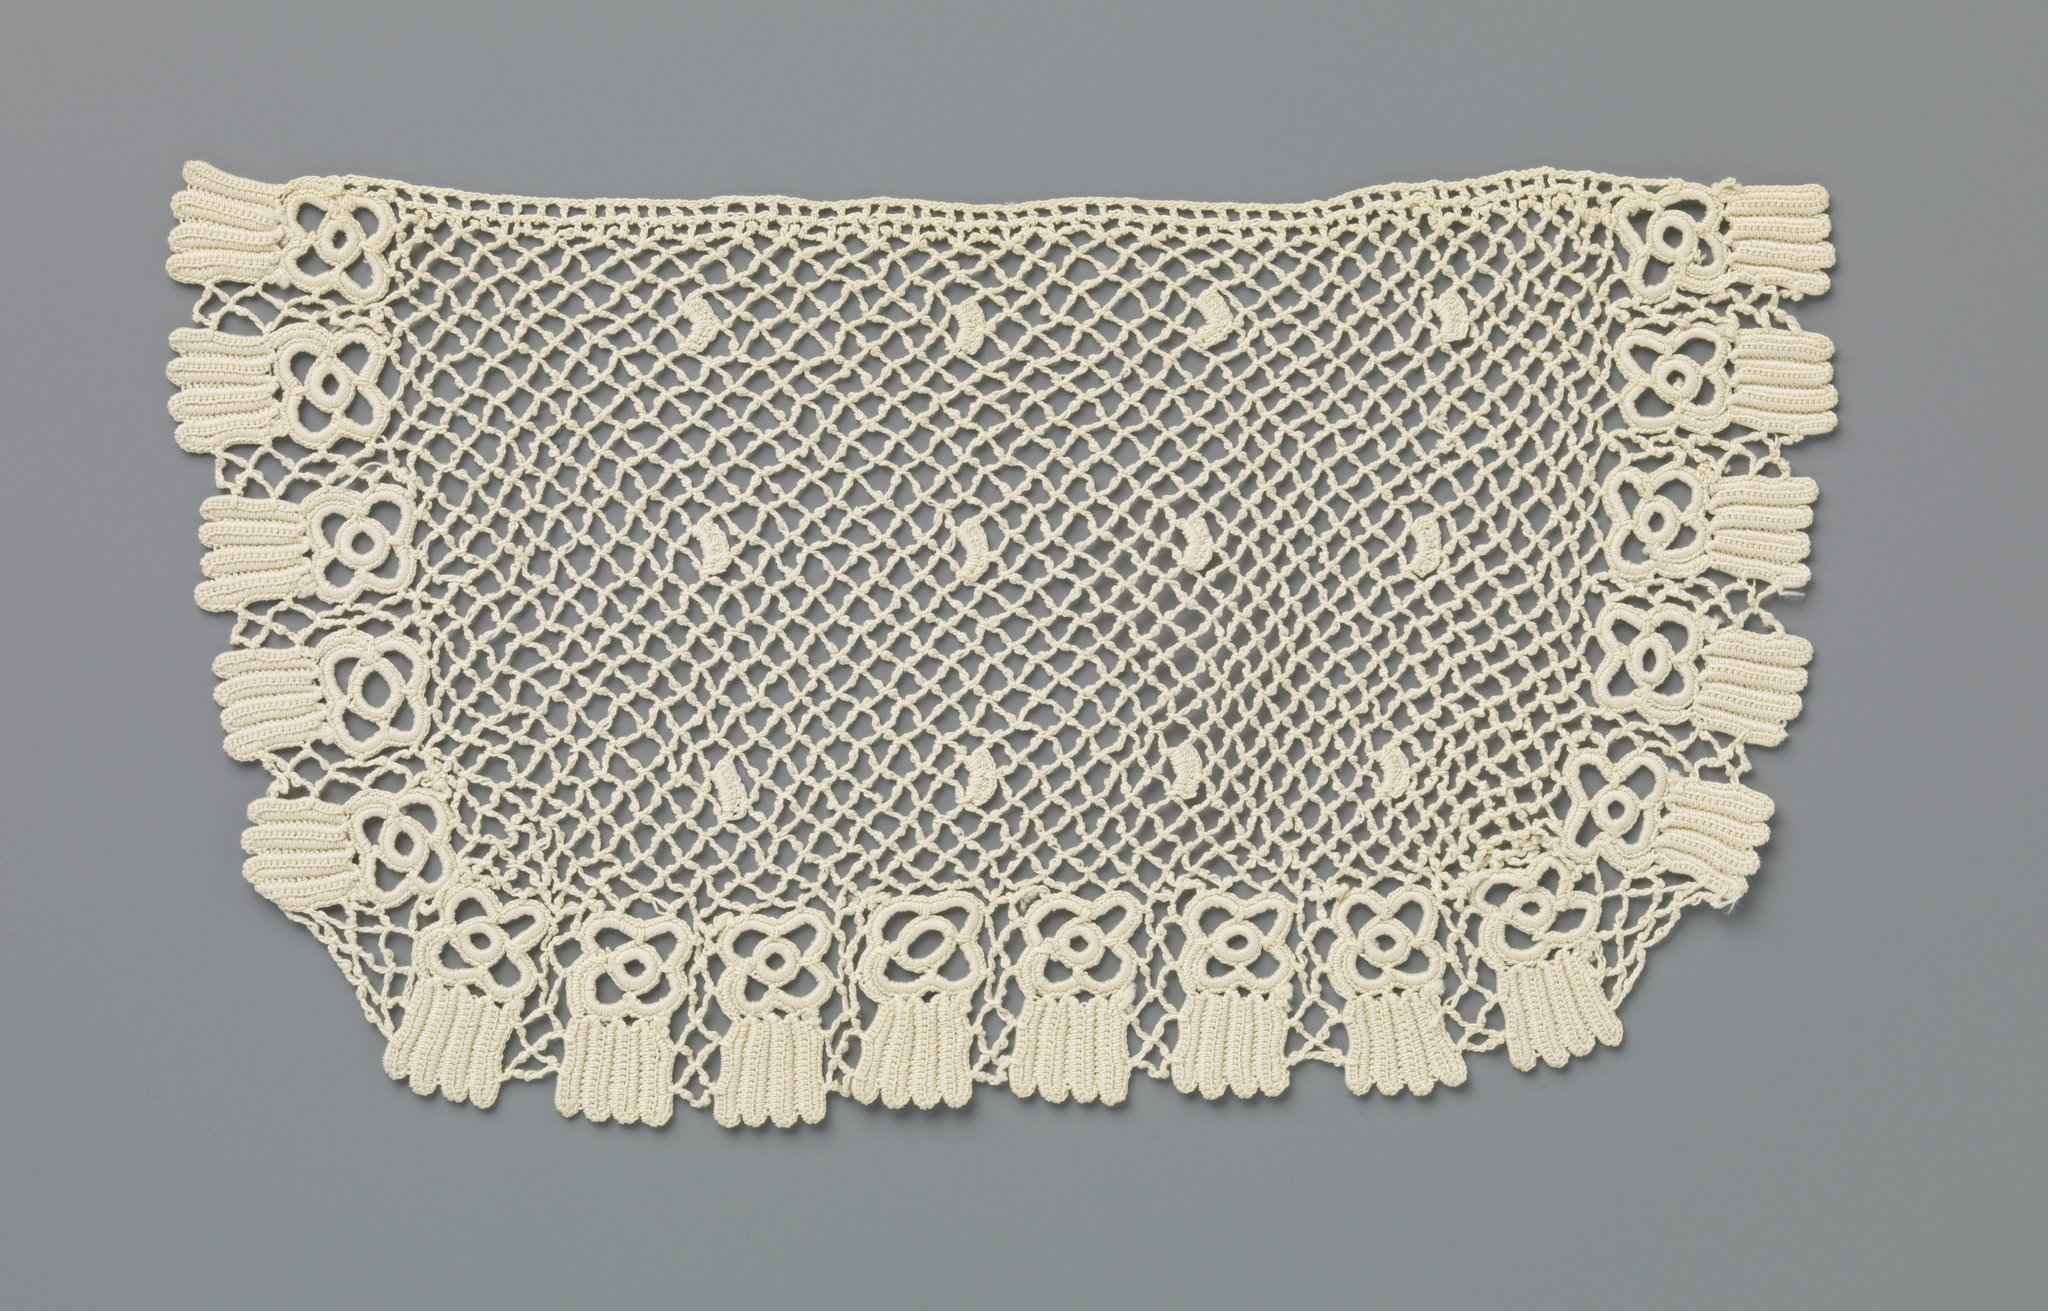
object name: cuff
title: Manchet van gehaakte kant met vierpassen en vierkante godronschulpen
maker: Anonymous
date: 1890-1900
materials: cotton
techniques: crocheted lace, irish crochet lace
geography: ireland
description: Manchet van naturelkleurige Ierse gehaakte kant. Rechthoekig model met afgeronde hoeken. Het middenveld bestaat uit een ruitvormig netwerk met drie rijen moesjes. De kraag is aan drie kanten afgewerkt met een aaneenschakeling van open vierpassen (rozetten met vier bloembladen). In het centrum van elke vierpas staat een cirkeltje. En onder elke vierpas een vierkante schulp, gevuld met godrons. De bovenzijde van de manchet is recht afgewerkt.